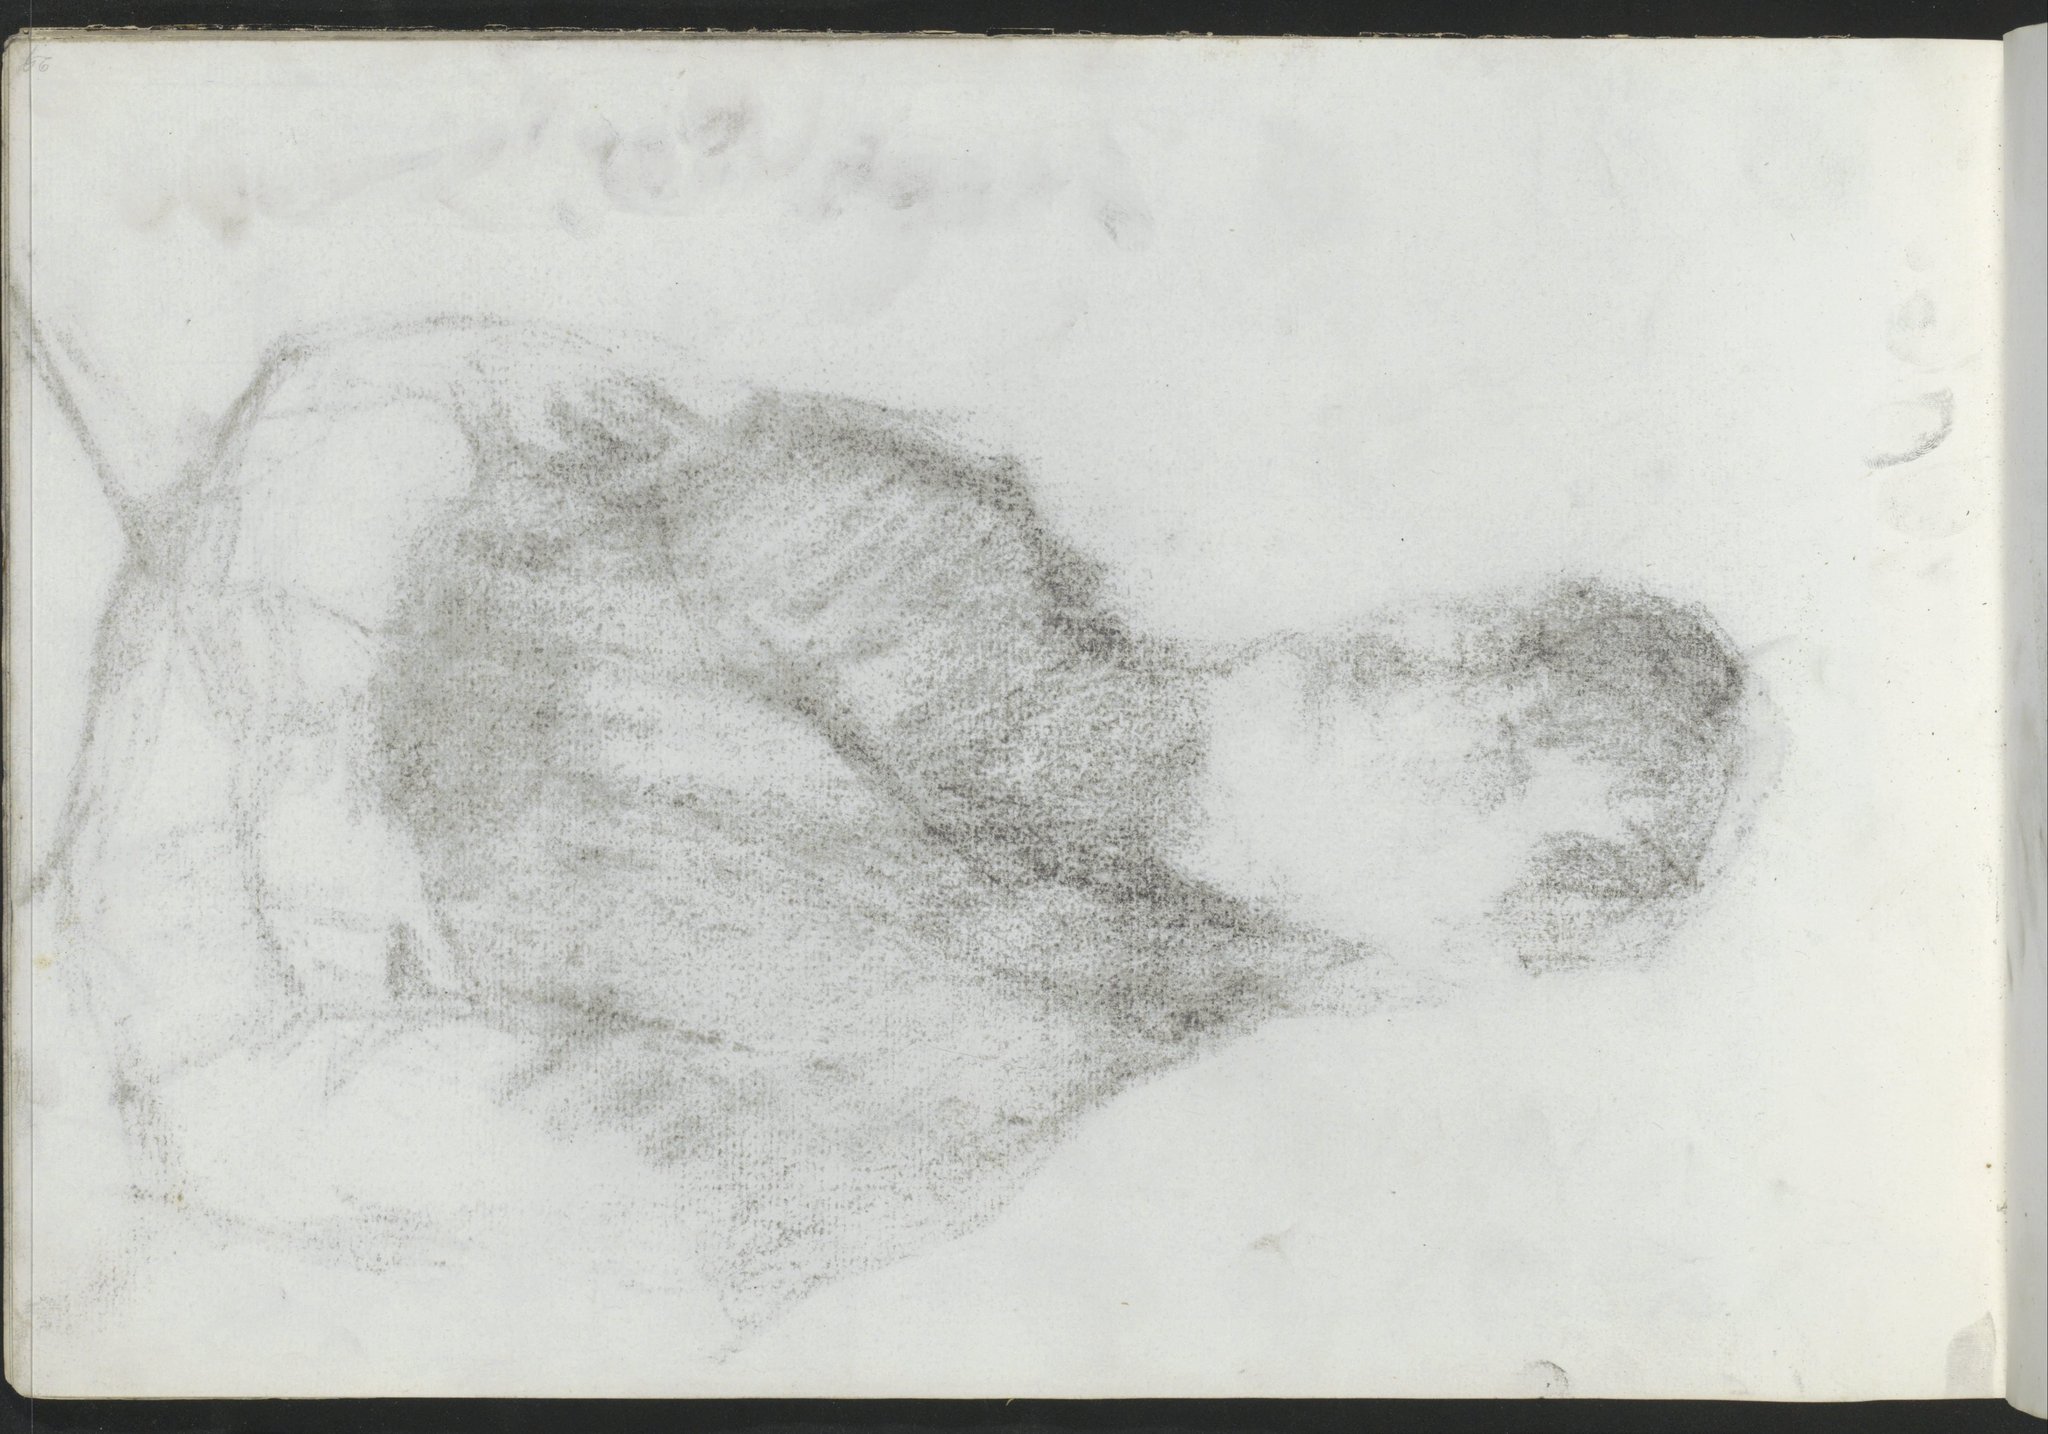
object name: sketchbook leaf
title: Abklatsch van de krijttekening op blad 7 recto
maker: isaac israels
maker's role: draughtsman, painter, print maker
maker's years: 1865-1934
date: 1886-1934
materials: paper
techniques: printmaking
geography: amsterdam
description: Blad 6 verso uit schetsboek LXX met 17 bladen.